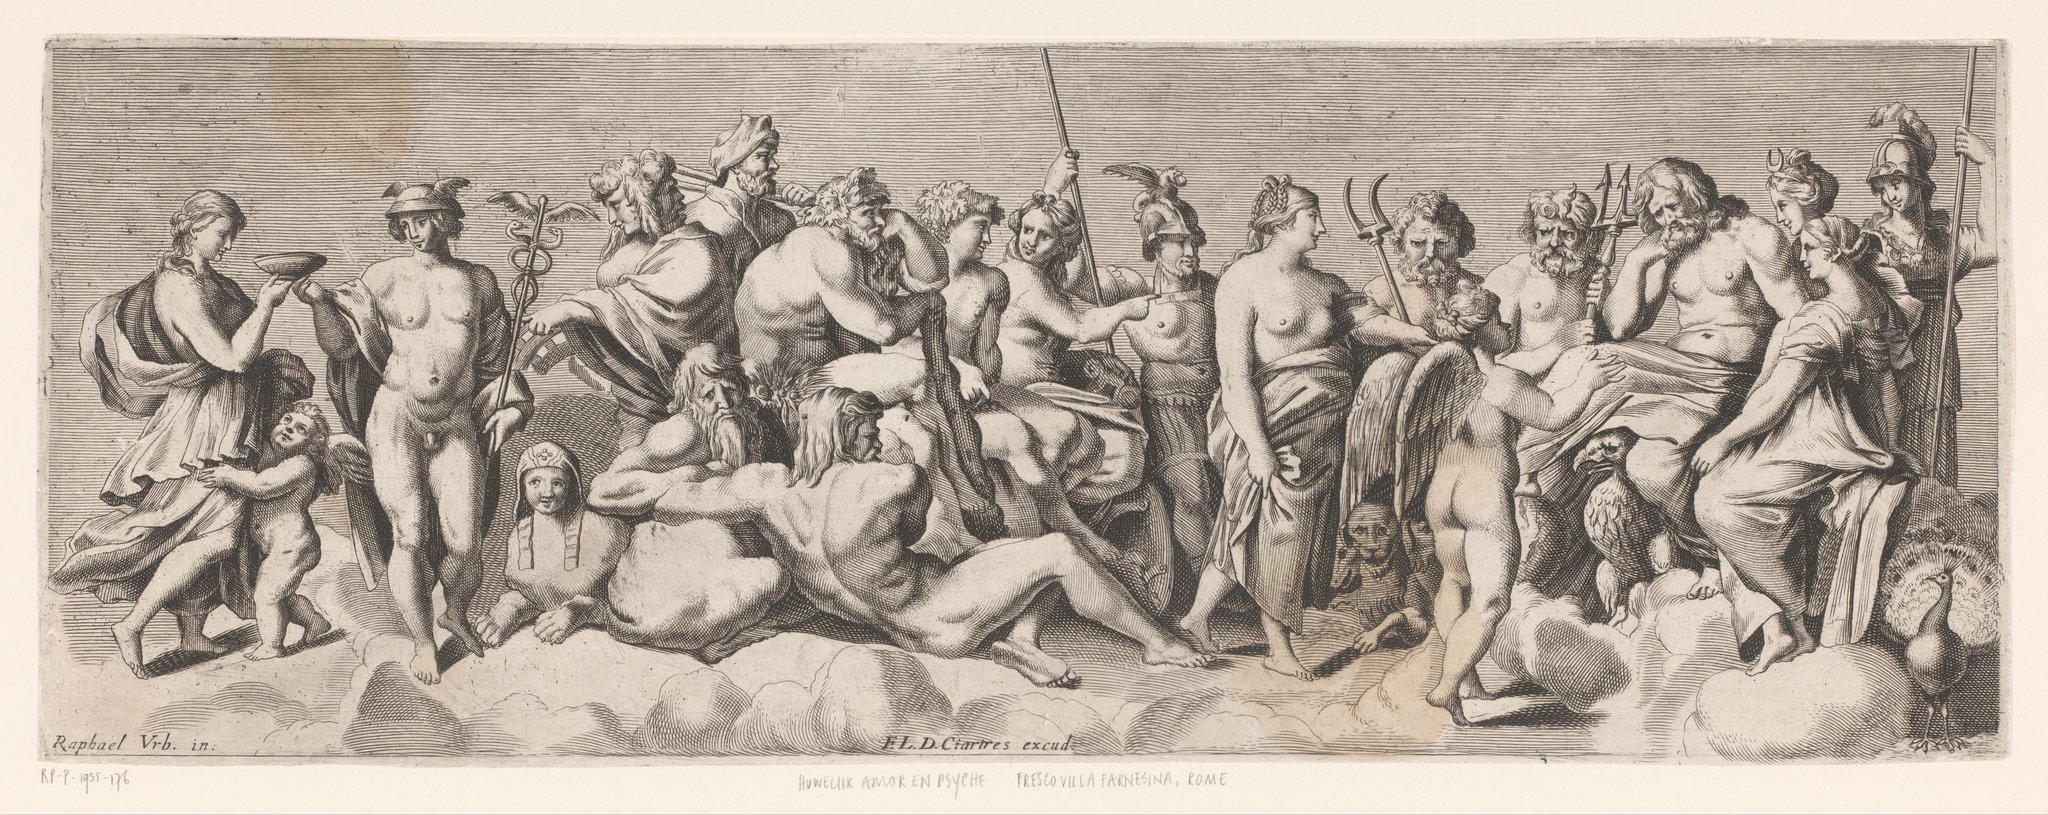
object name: print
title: Bijeenkomst van goden op de Olympus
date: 1599-1647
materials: paper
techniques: engraving, etching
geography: rome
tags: assemblies of the gods in the air, possibly on the clouds, olympus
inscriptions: collector's mark: Lugt 2228